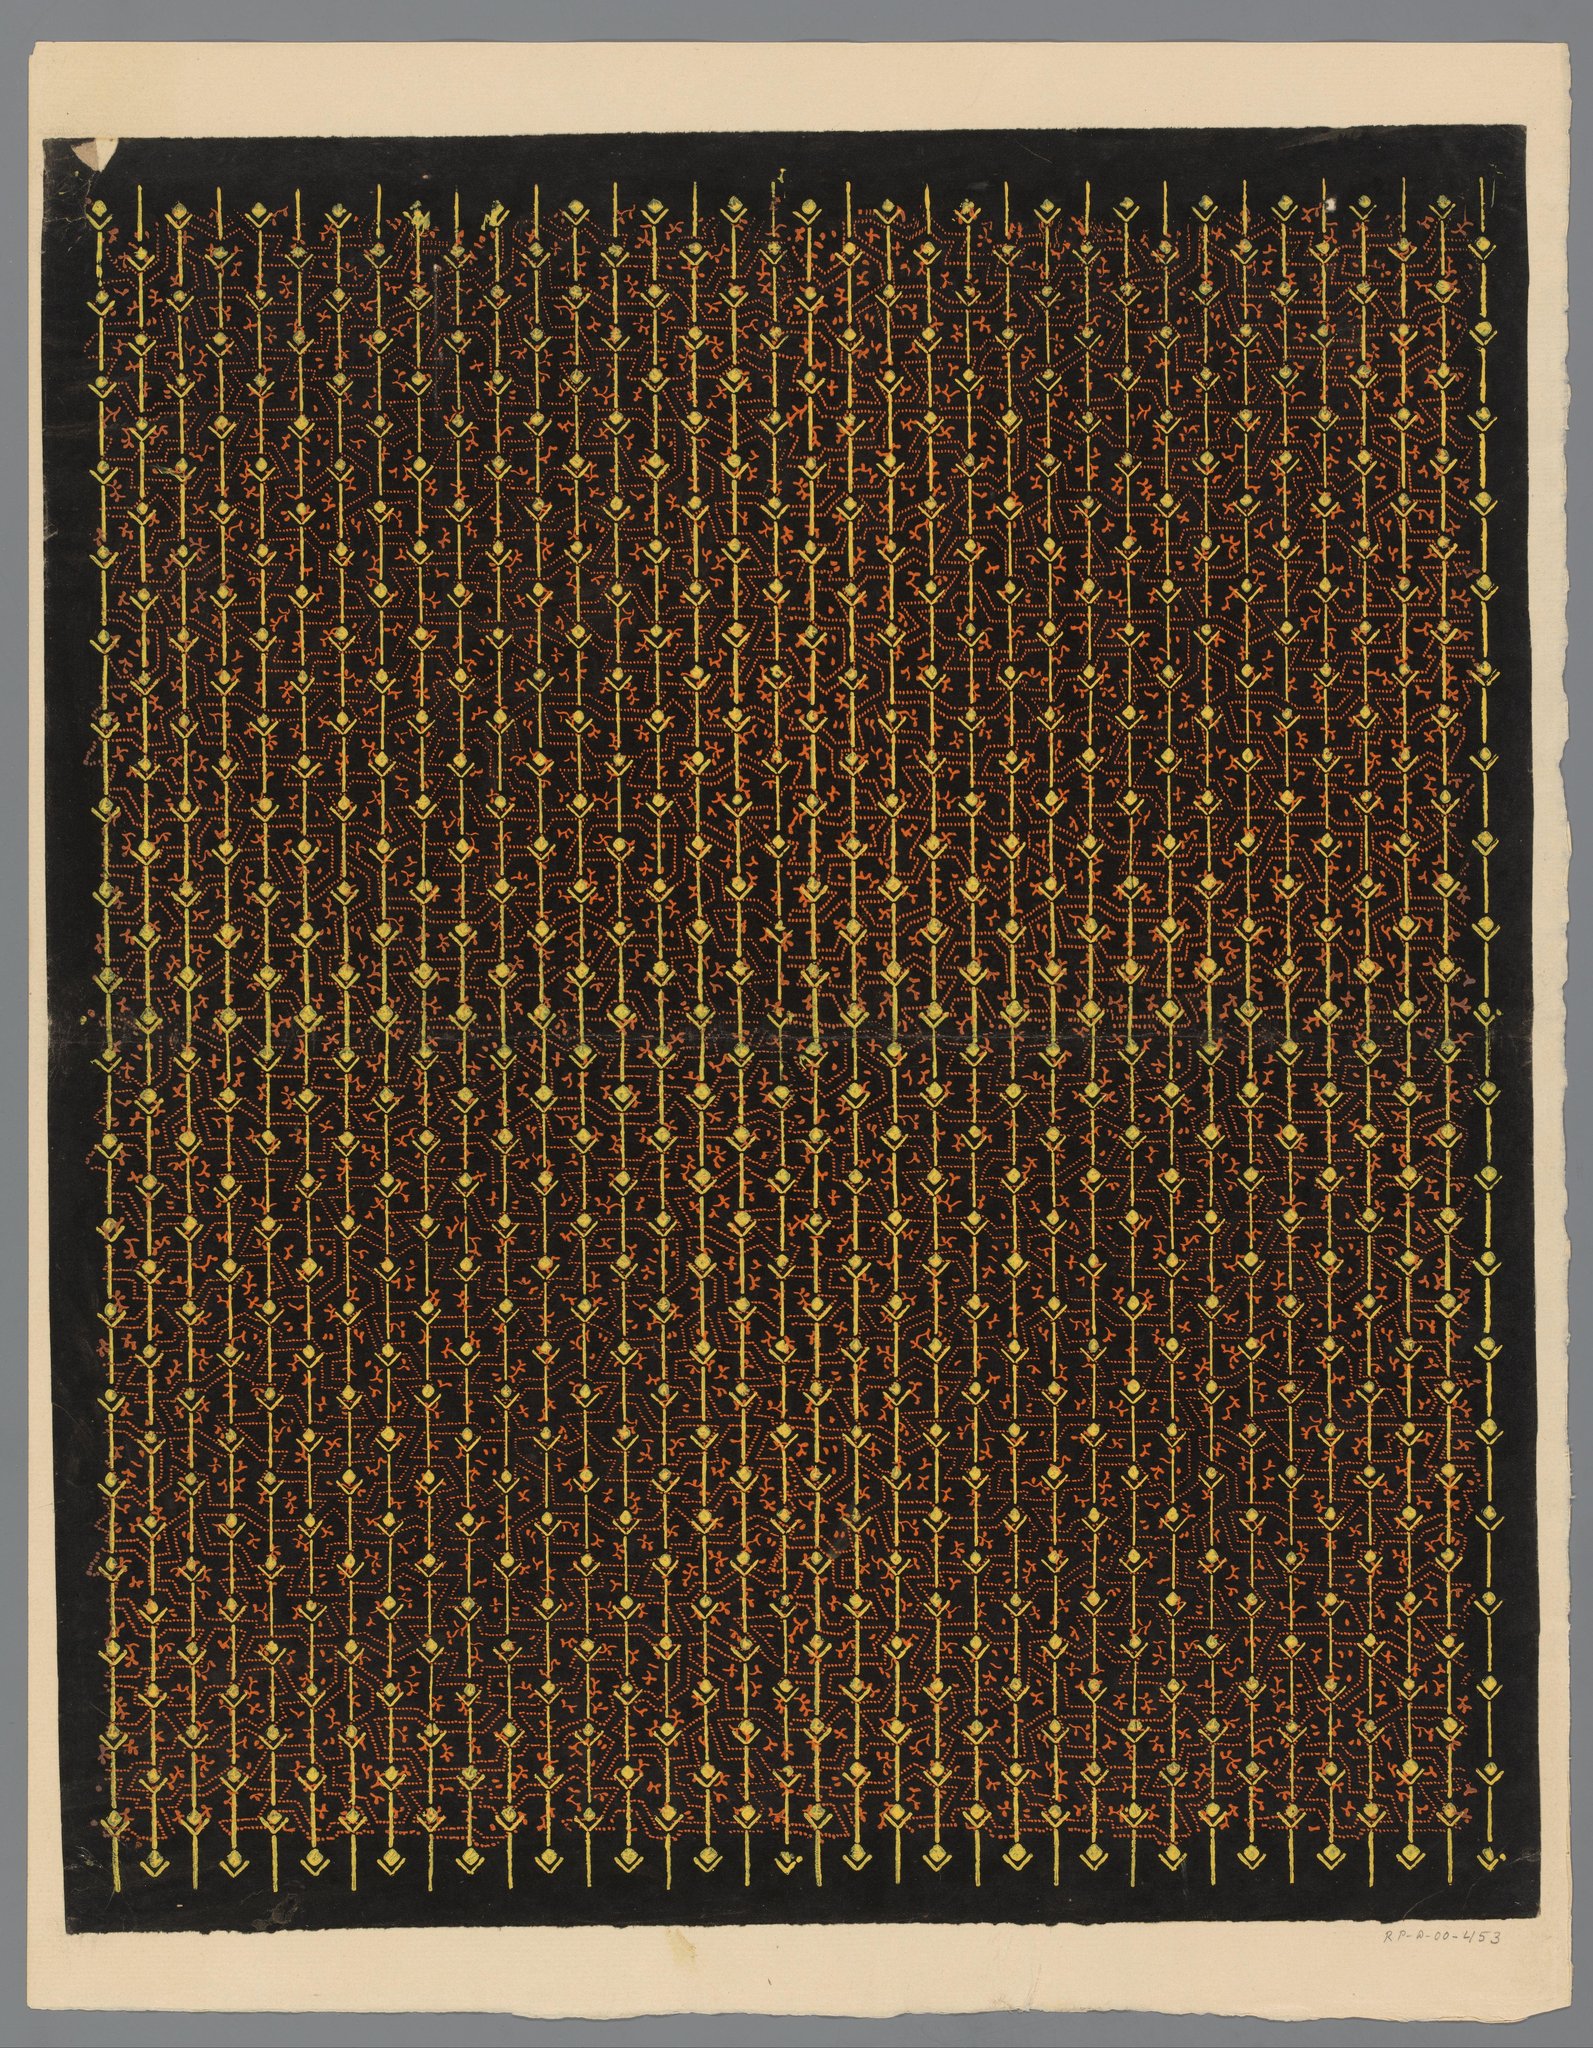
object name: printed paper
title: Blad met regelmatig banenpatroon van strepen en blokjes over kronkelende lijnpatroon van punten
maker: Anonymous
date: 1800-1900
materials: paint, paper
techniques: printing block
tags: ornament ~ geometric motifs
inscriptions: collector's mark: Lugt 2760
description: Blad met regelmatig banenpatroon van verticale strepen en blokjes over een kronkelende lijnpatroon van punten.